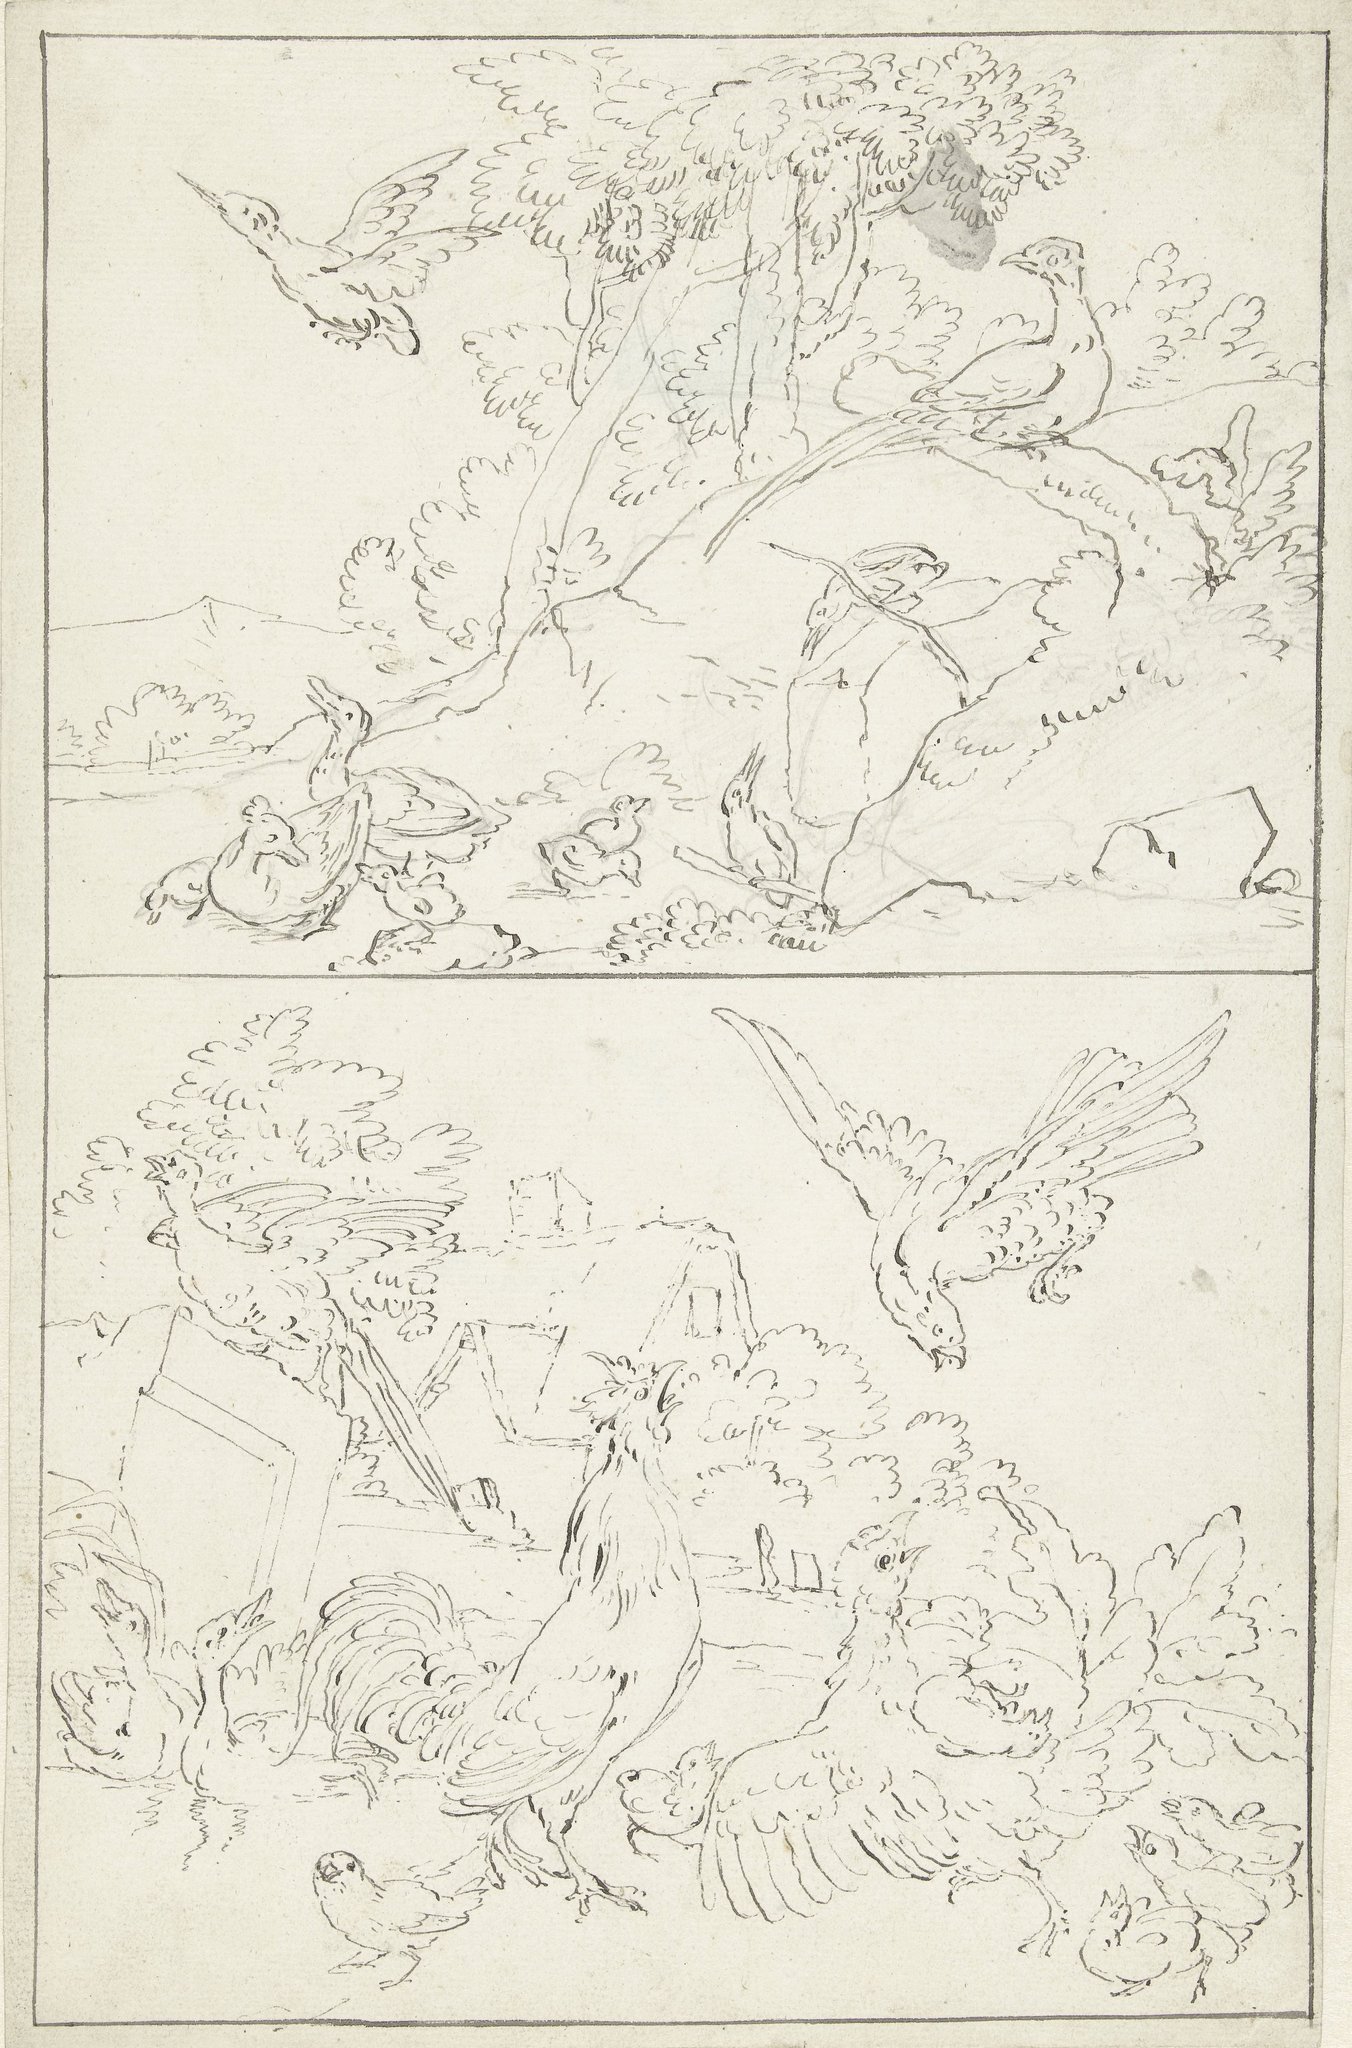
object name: drawing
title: Ontwerp voor een kamerversiering: twee panelen met vogels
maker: abraham meertens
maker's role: draughtsman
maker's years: 1757-1823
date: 1767-1823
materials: ink, paper, pencil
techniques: pen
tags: groups of birds